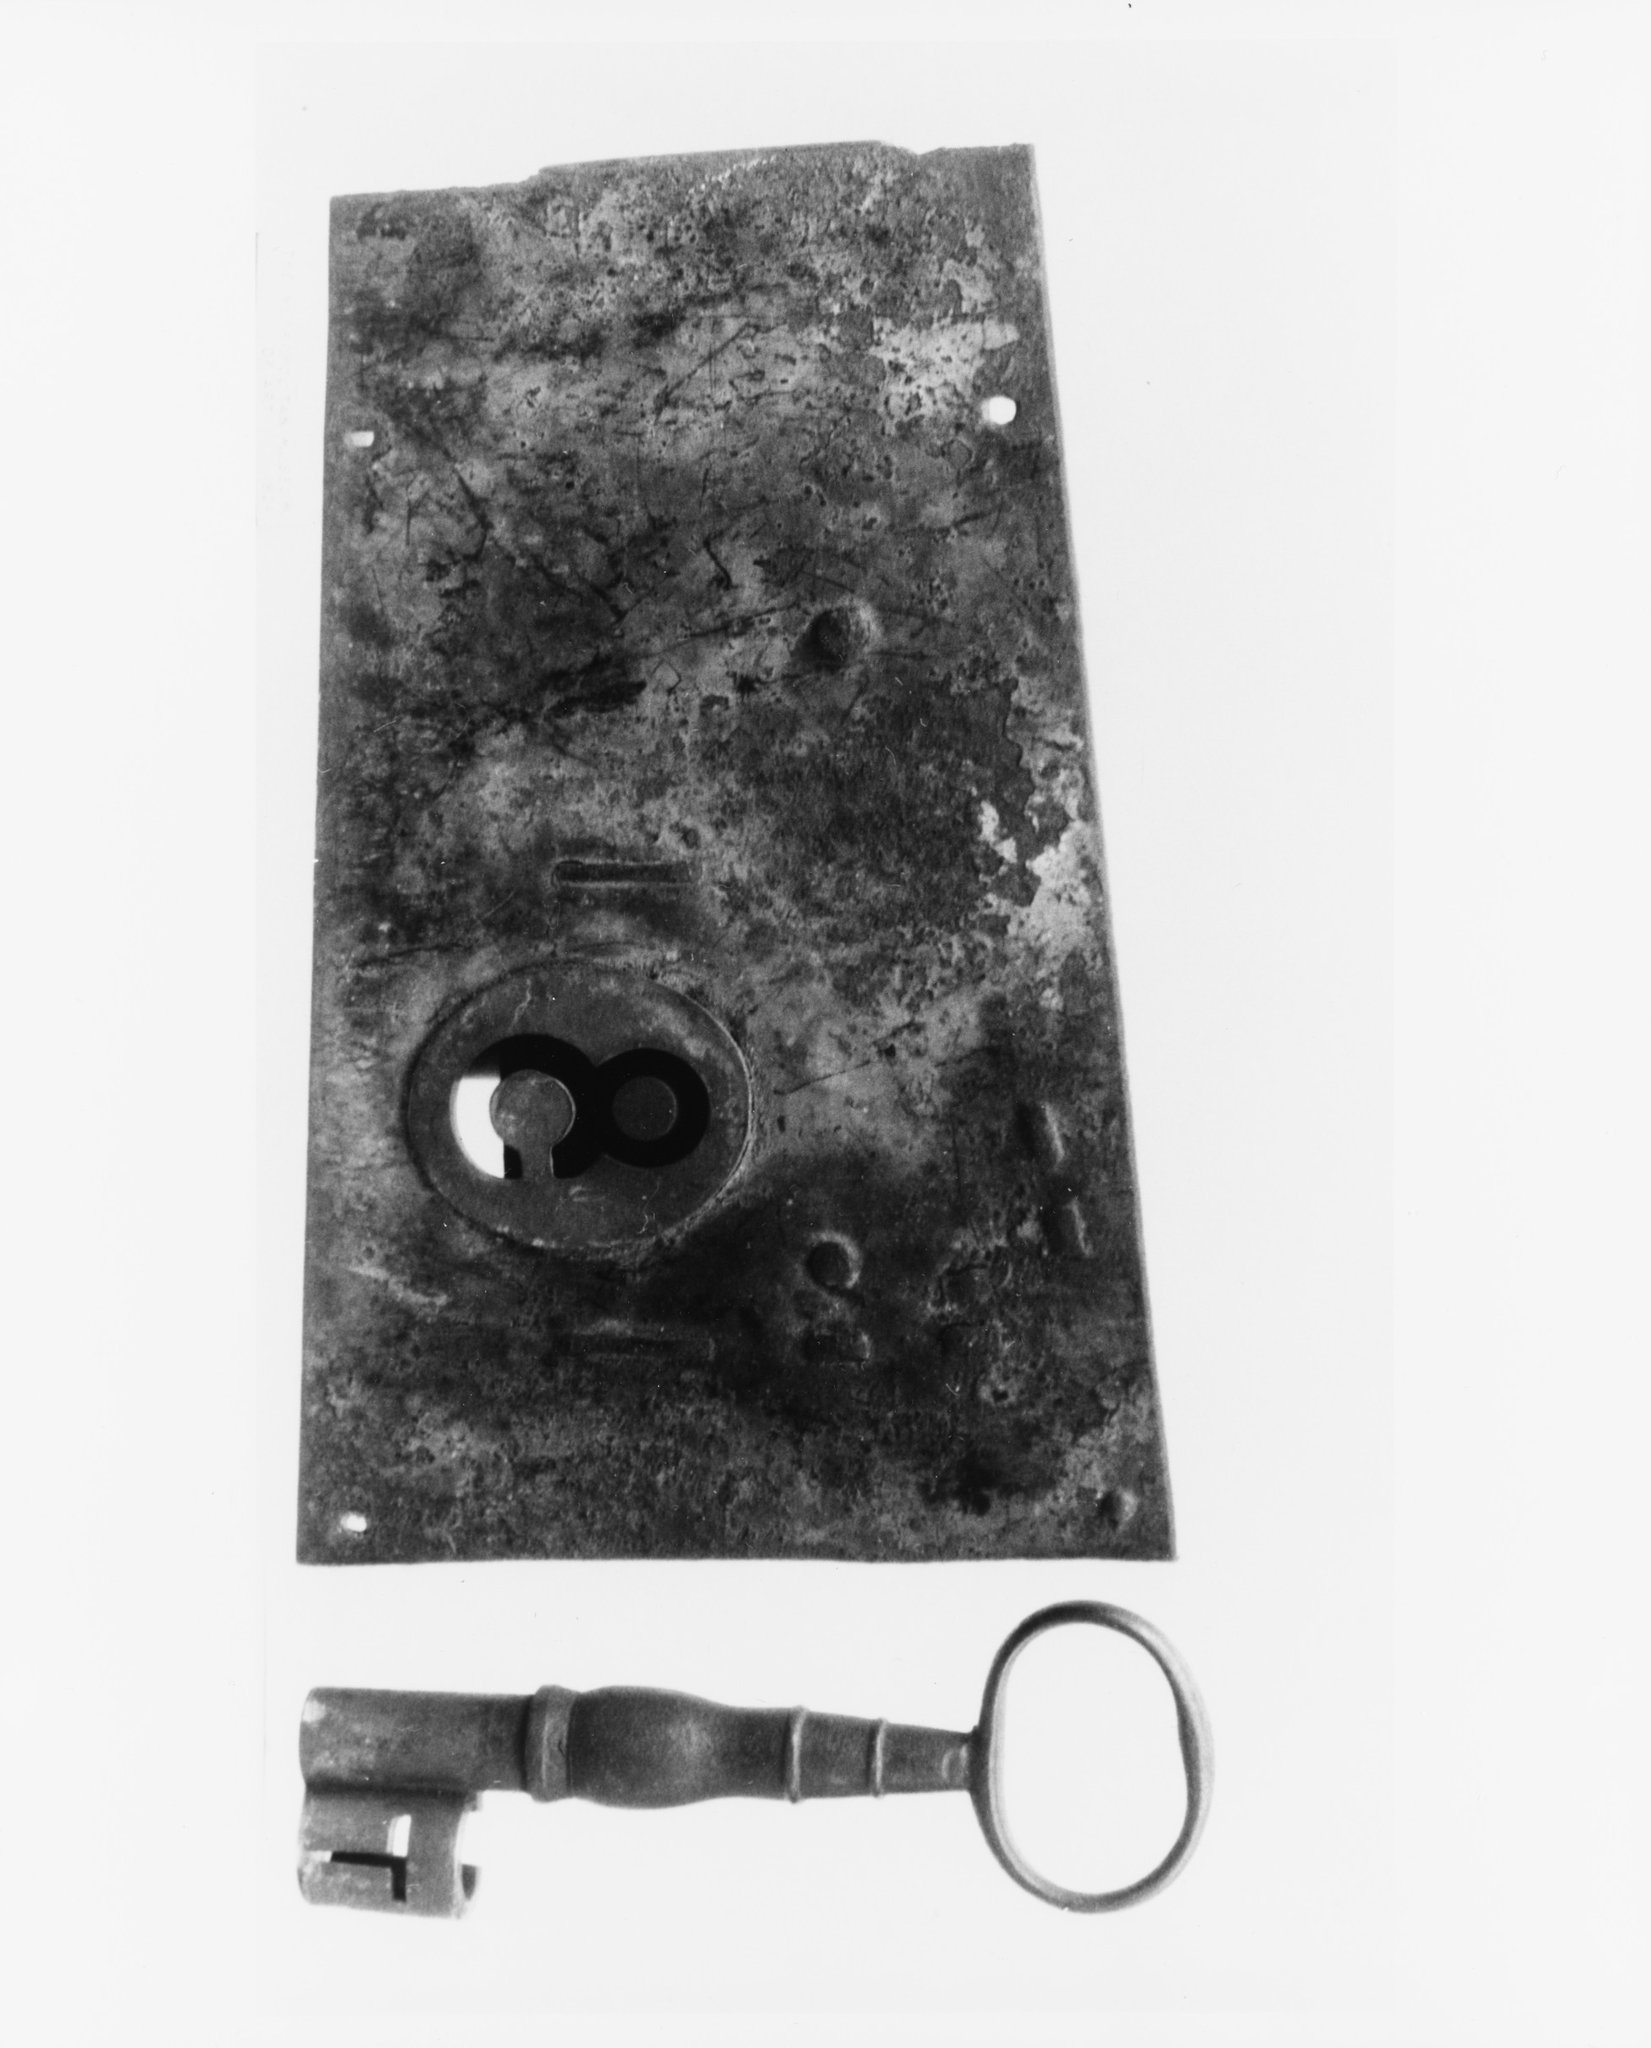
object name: lock and key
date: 1700-1730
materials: iron, wood